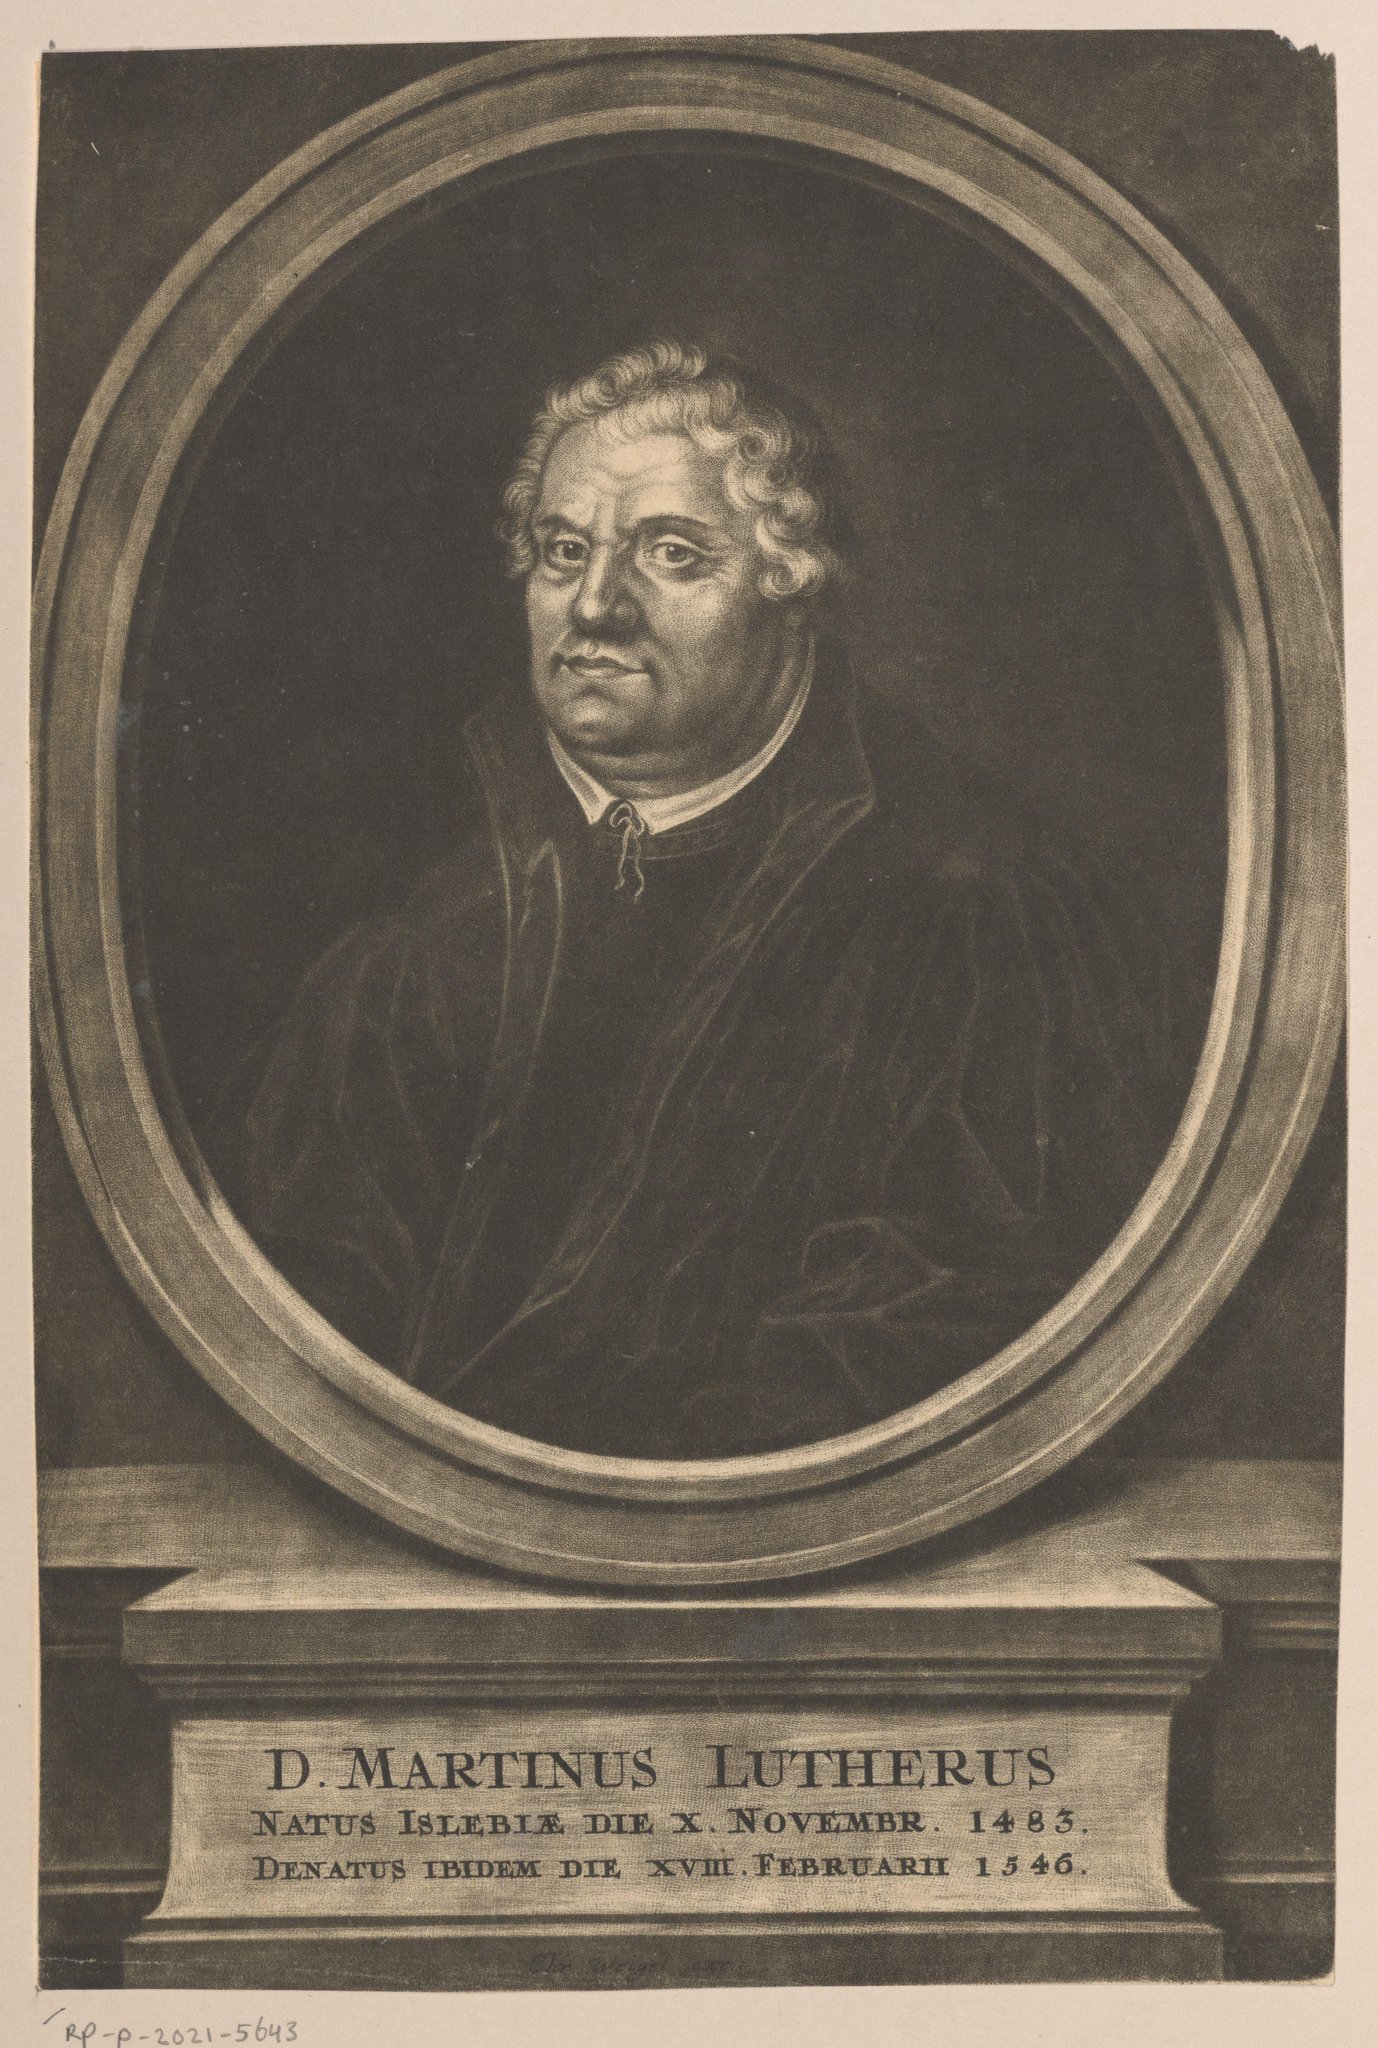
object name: print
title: Portret van Martin Luther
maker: christoph weigel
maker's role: goldsmith, print maker, publisher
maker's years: 1654-1725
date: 1680-1725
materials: paper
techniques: mezzotint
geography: germany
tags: priest, martin luther, theologian, ornament ~ medallion, historical persons